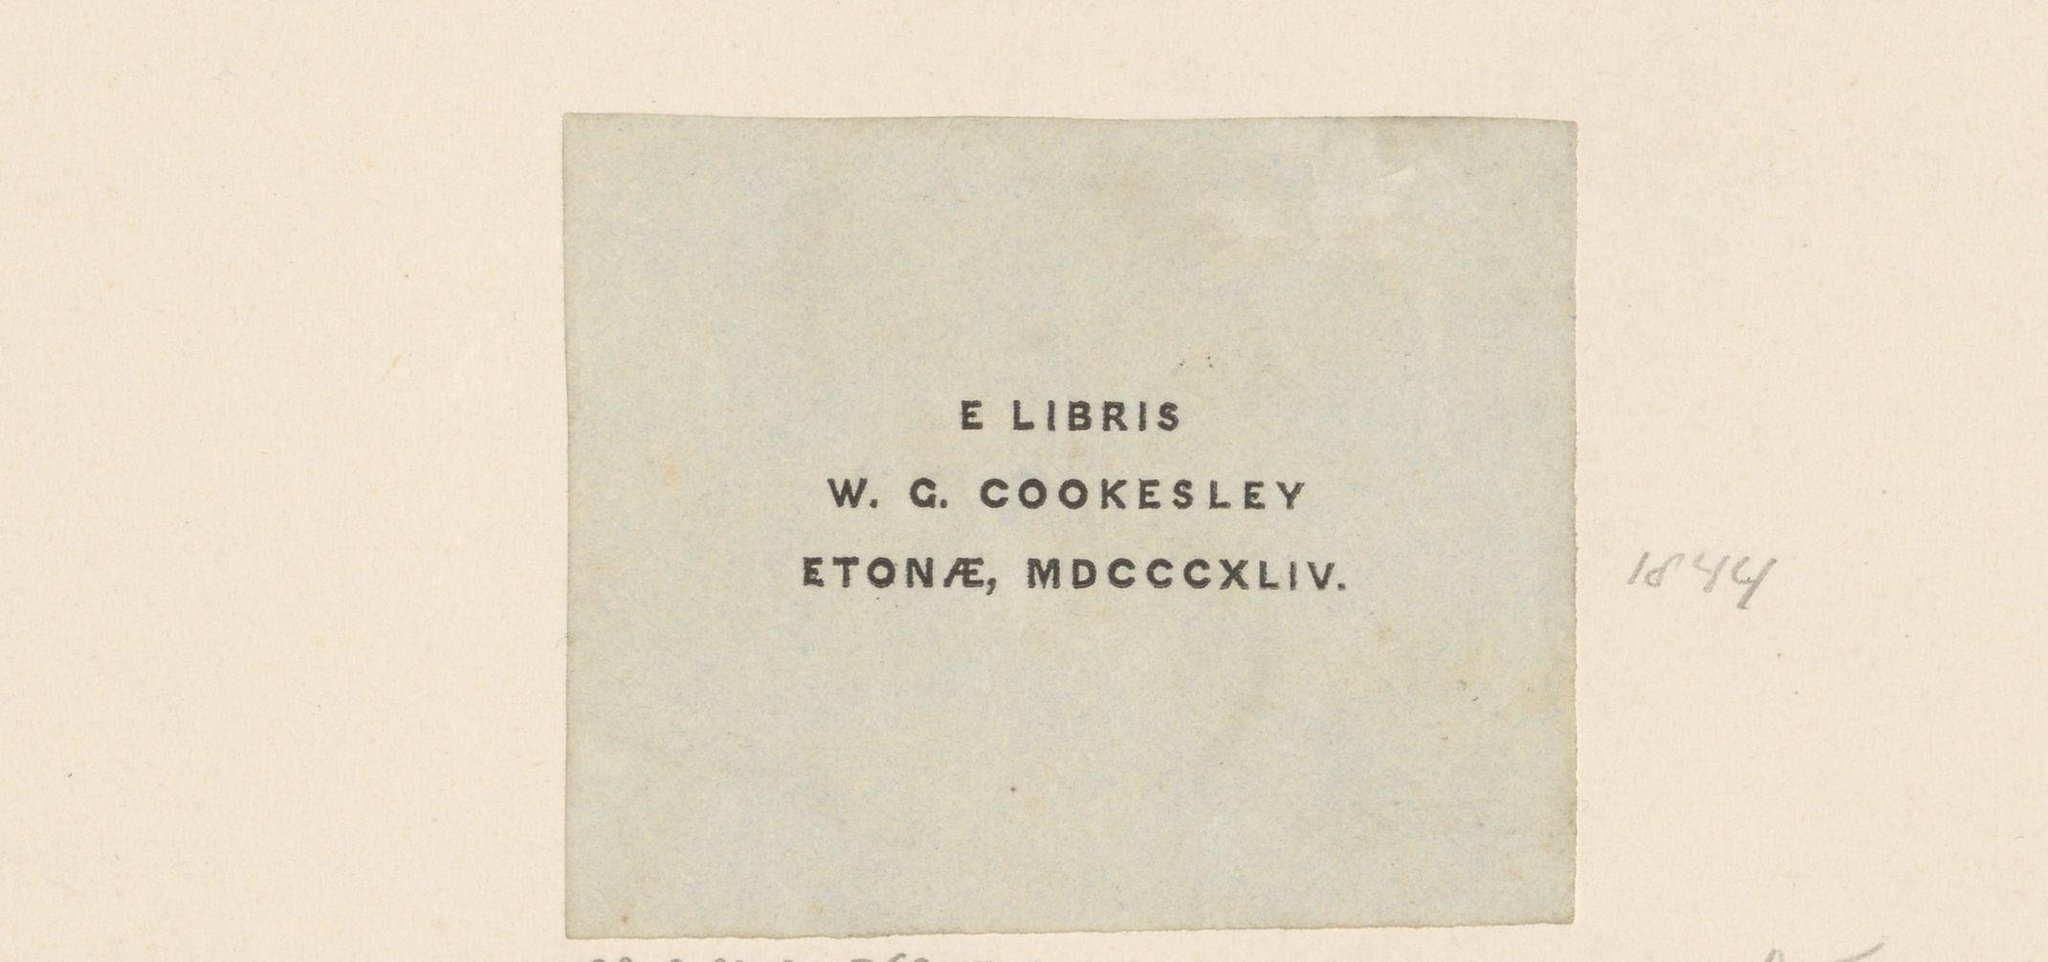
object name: bookplate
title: Ex libris van W.G. Cookesley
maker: Anonymous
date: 1844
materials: paper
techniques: letterpress printing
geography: england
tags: pastoor, classicus, william gifford cookesley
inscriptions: date